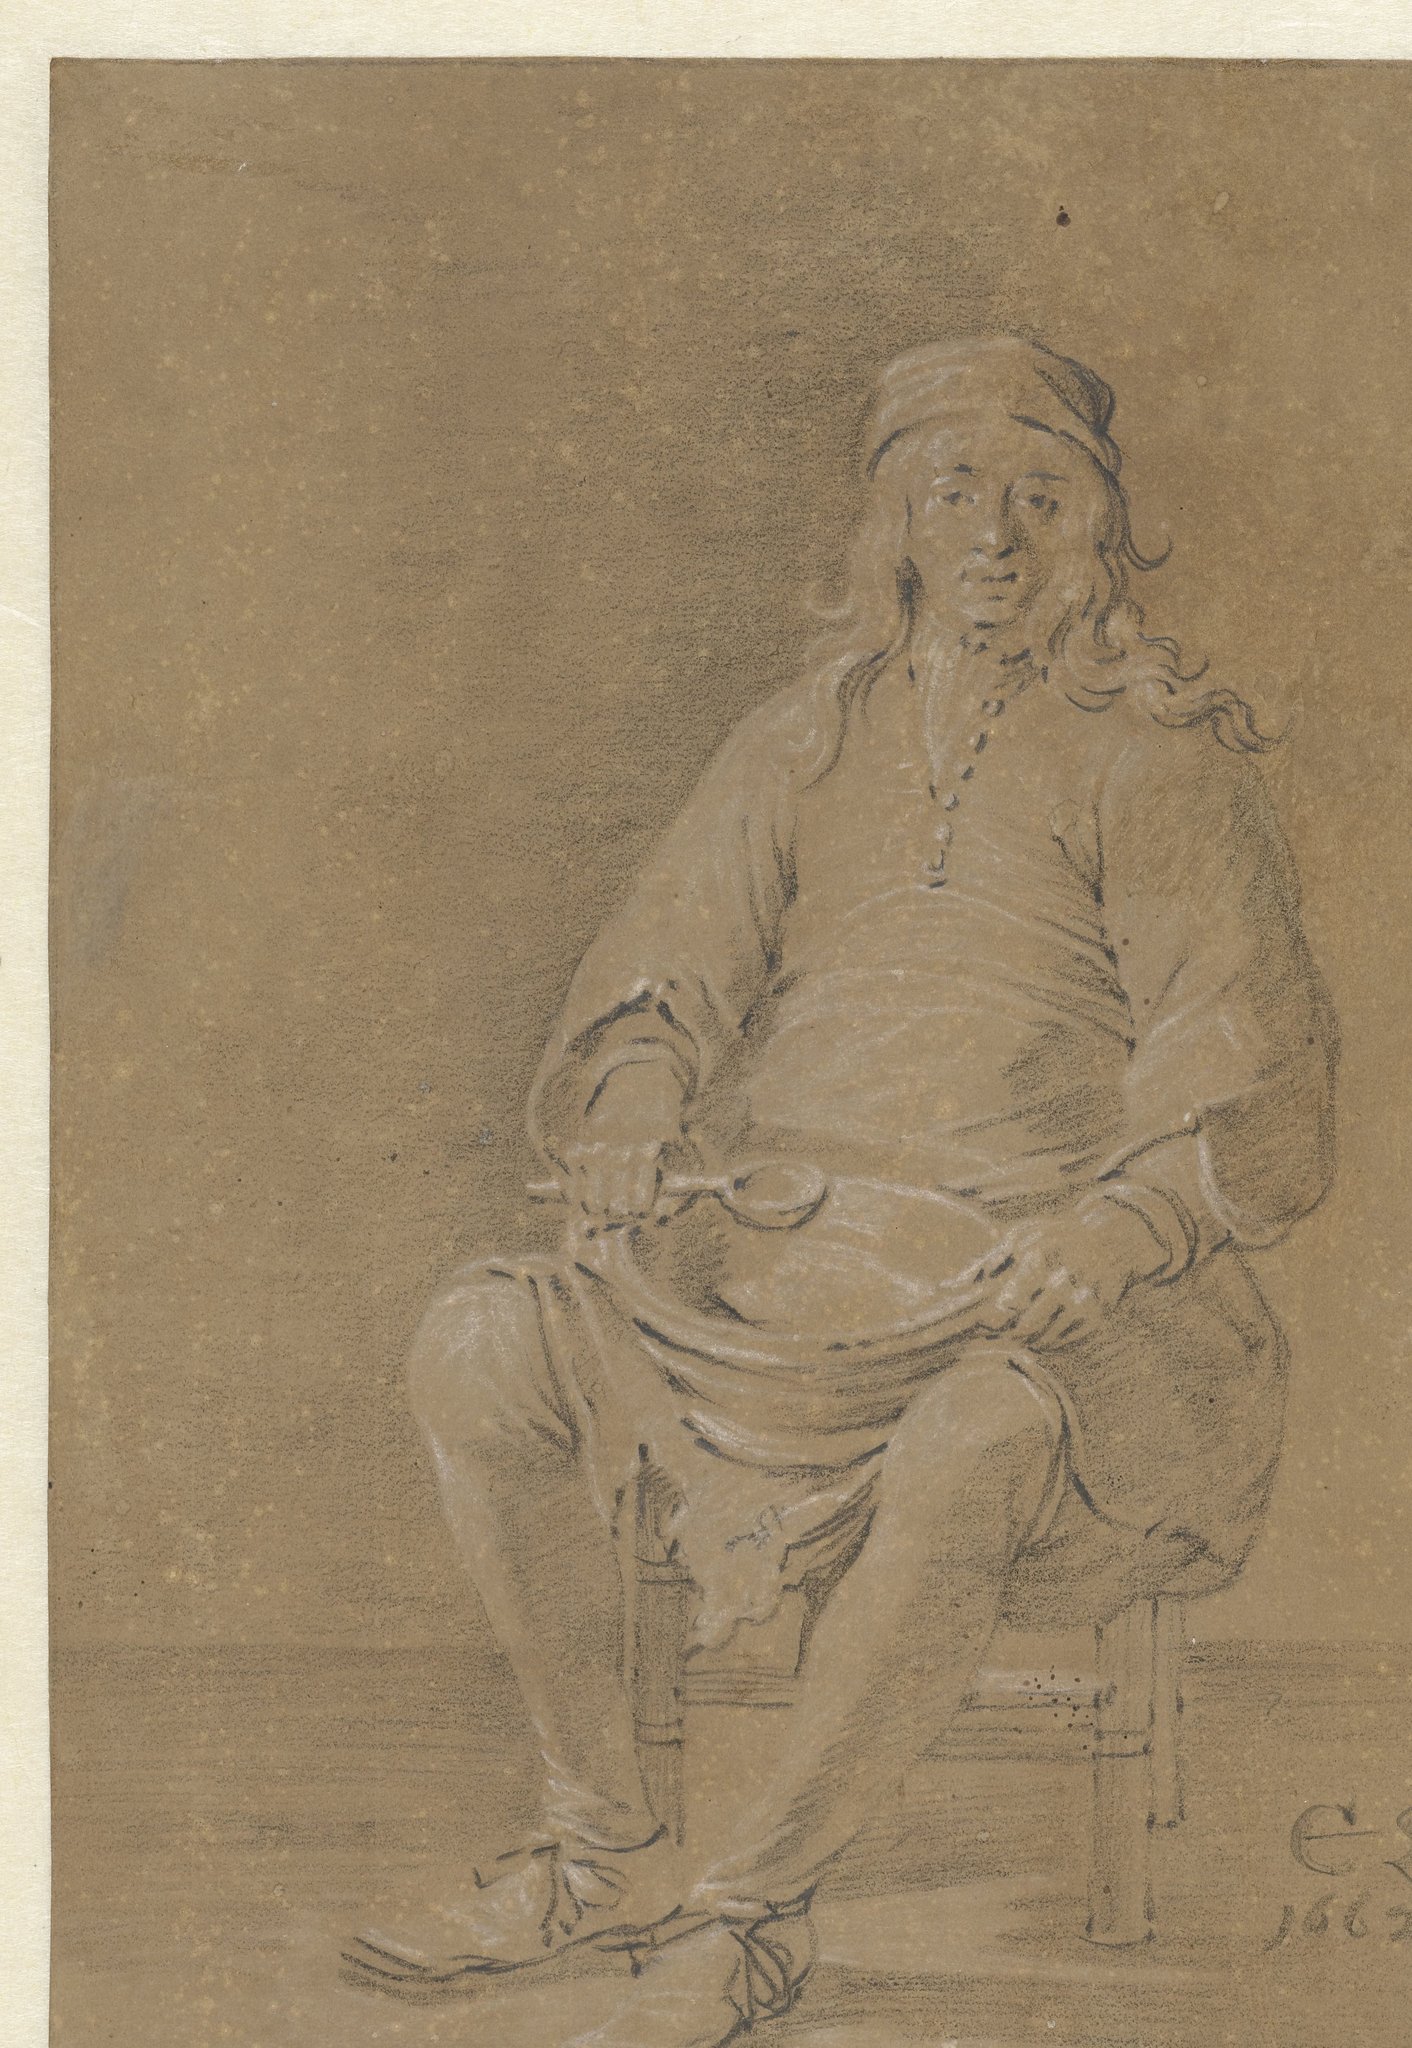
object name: drawing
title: Seated Man with a Bowl and a Spoon in his Lap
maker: cornelis saftleven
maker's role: draughtsman, painter, print maker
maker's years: 1607-1681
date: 1662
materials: chalk, paint, paper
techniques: drawing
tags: sitting figure